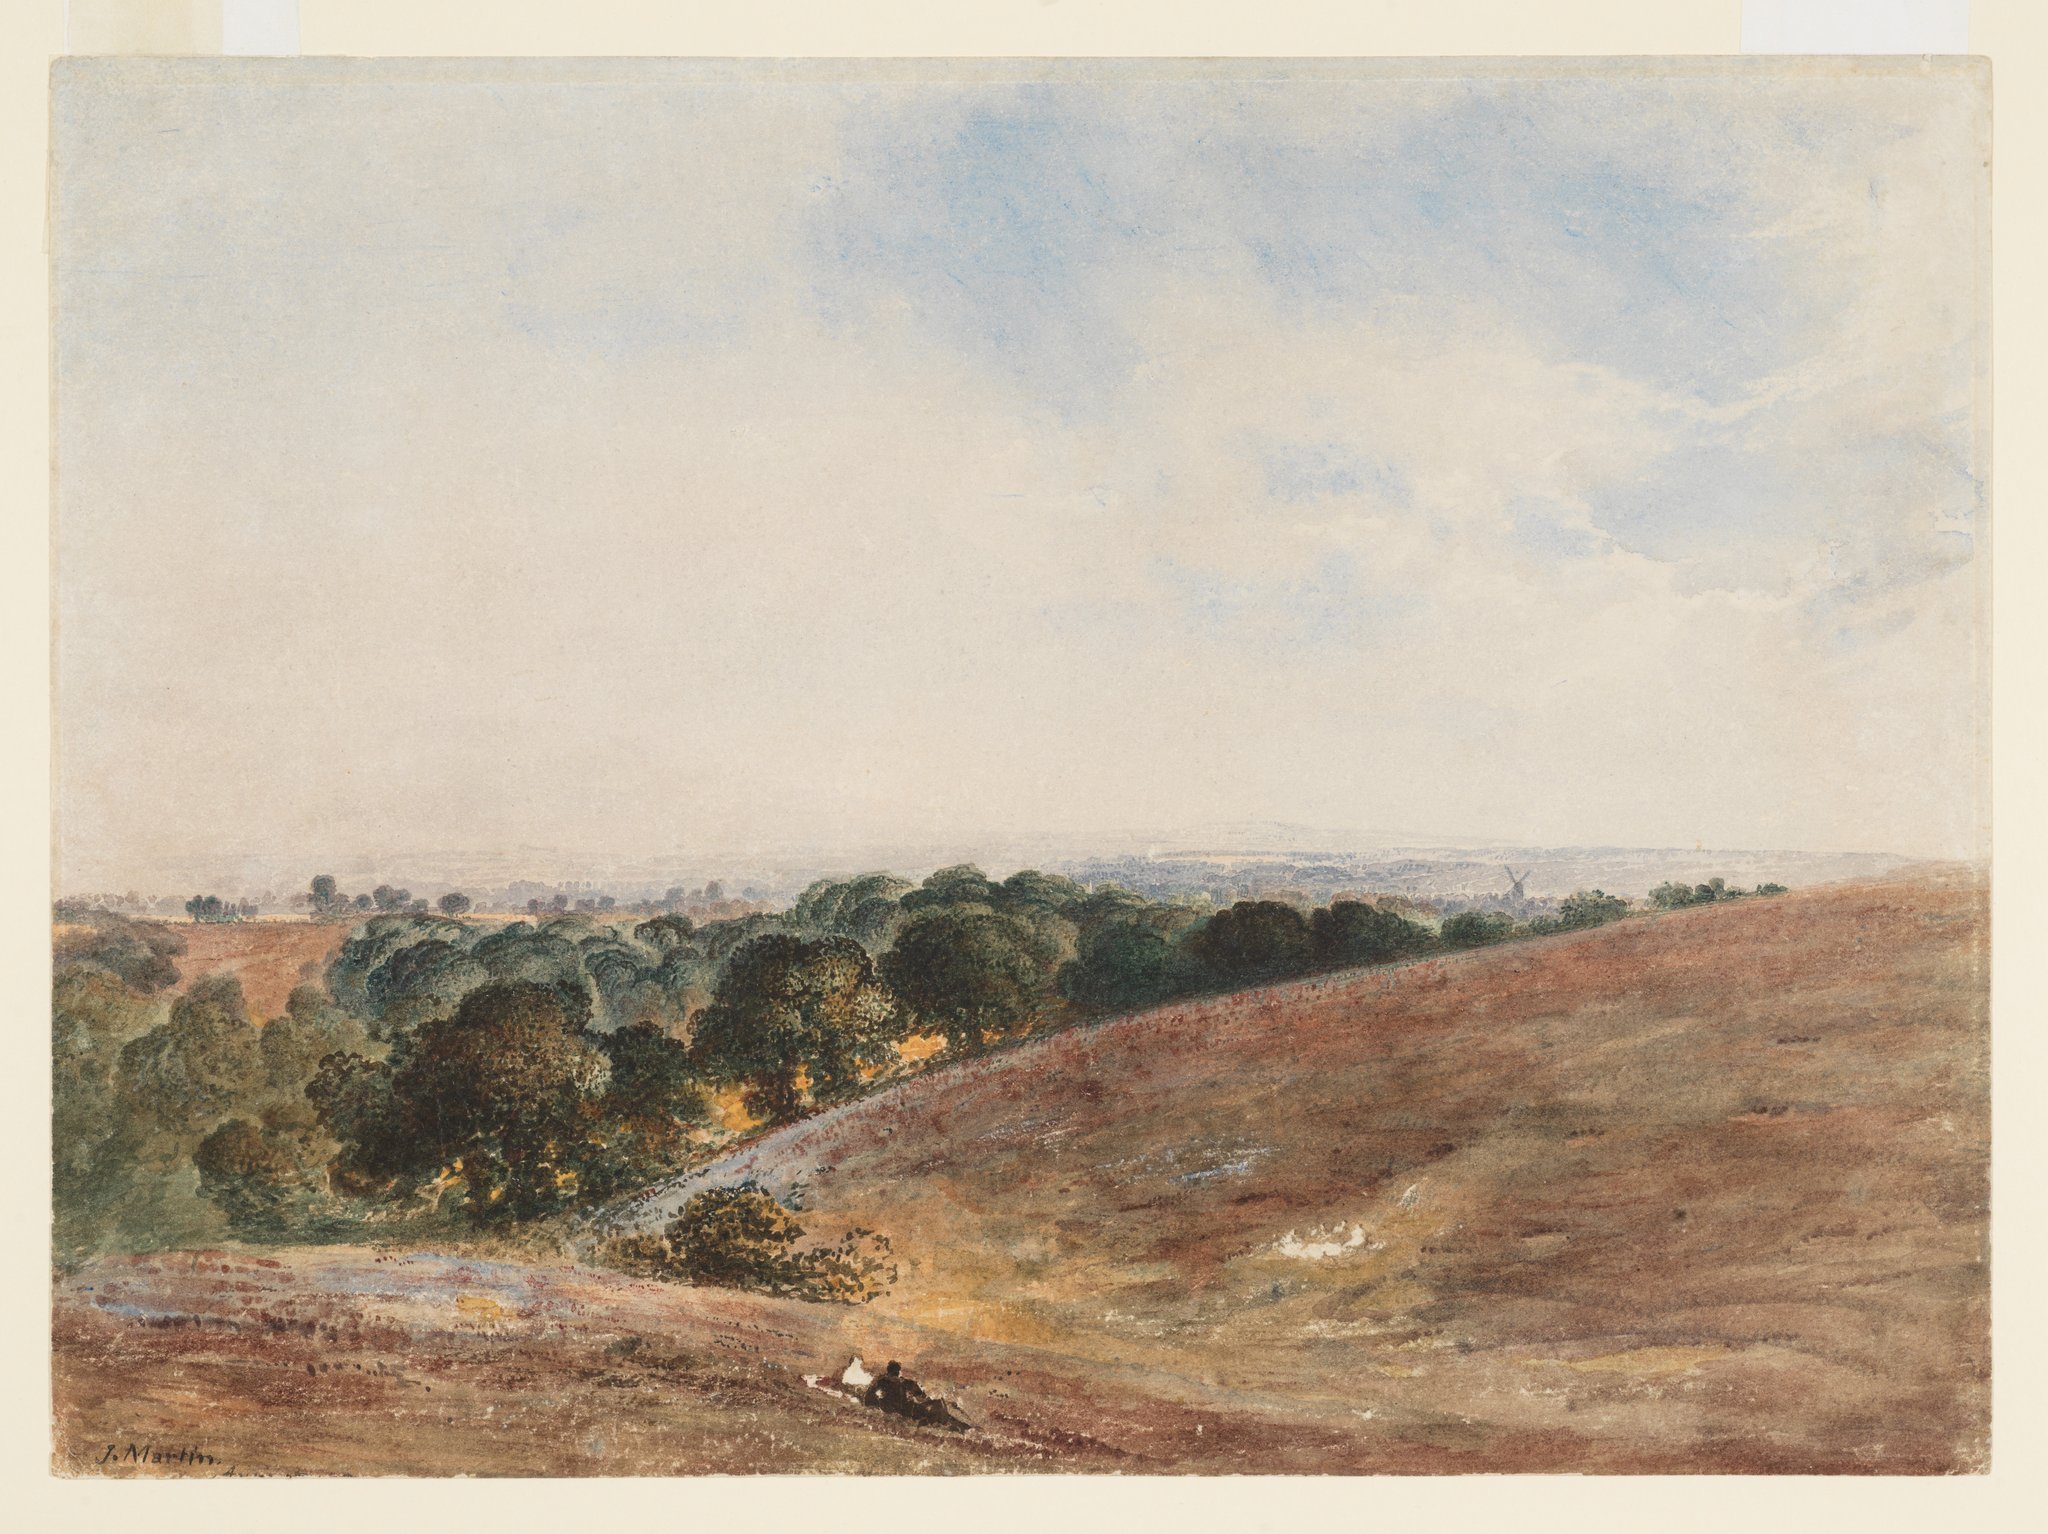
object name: drawing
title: View on the South Downs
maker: john martin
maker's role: artist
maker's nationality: british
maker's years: 1789-1854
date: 1840-1849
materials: watercolor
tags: landscapes